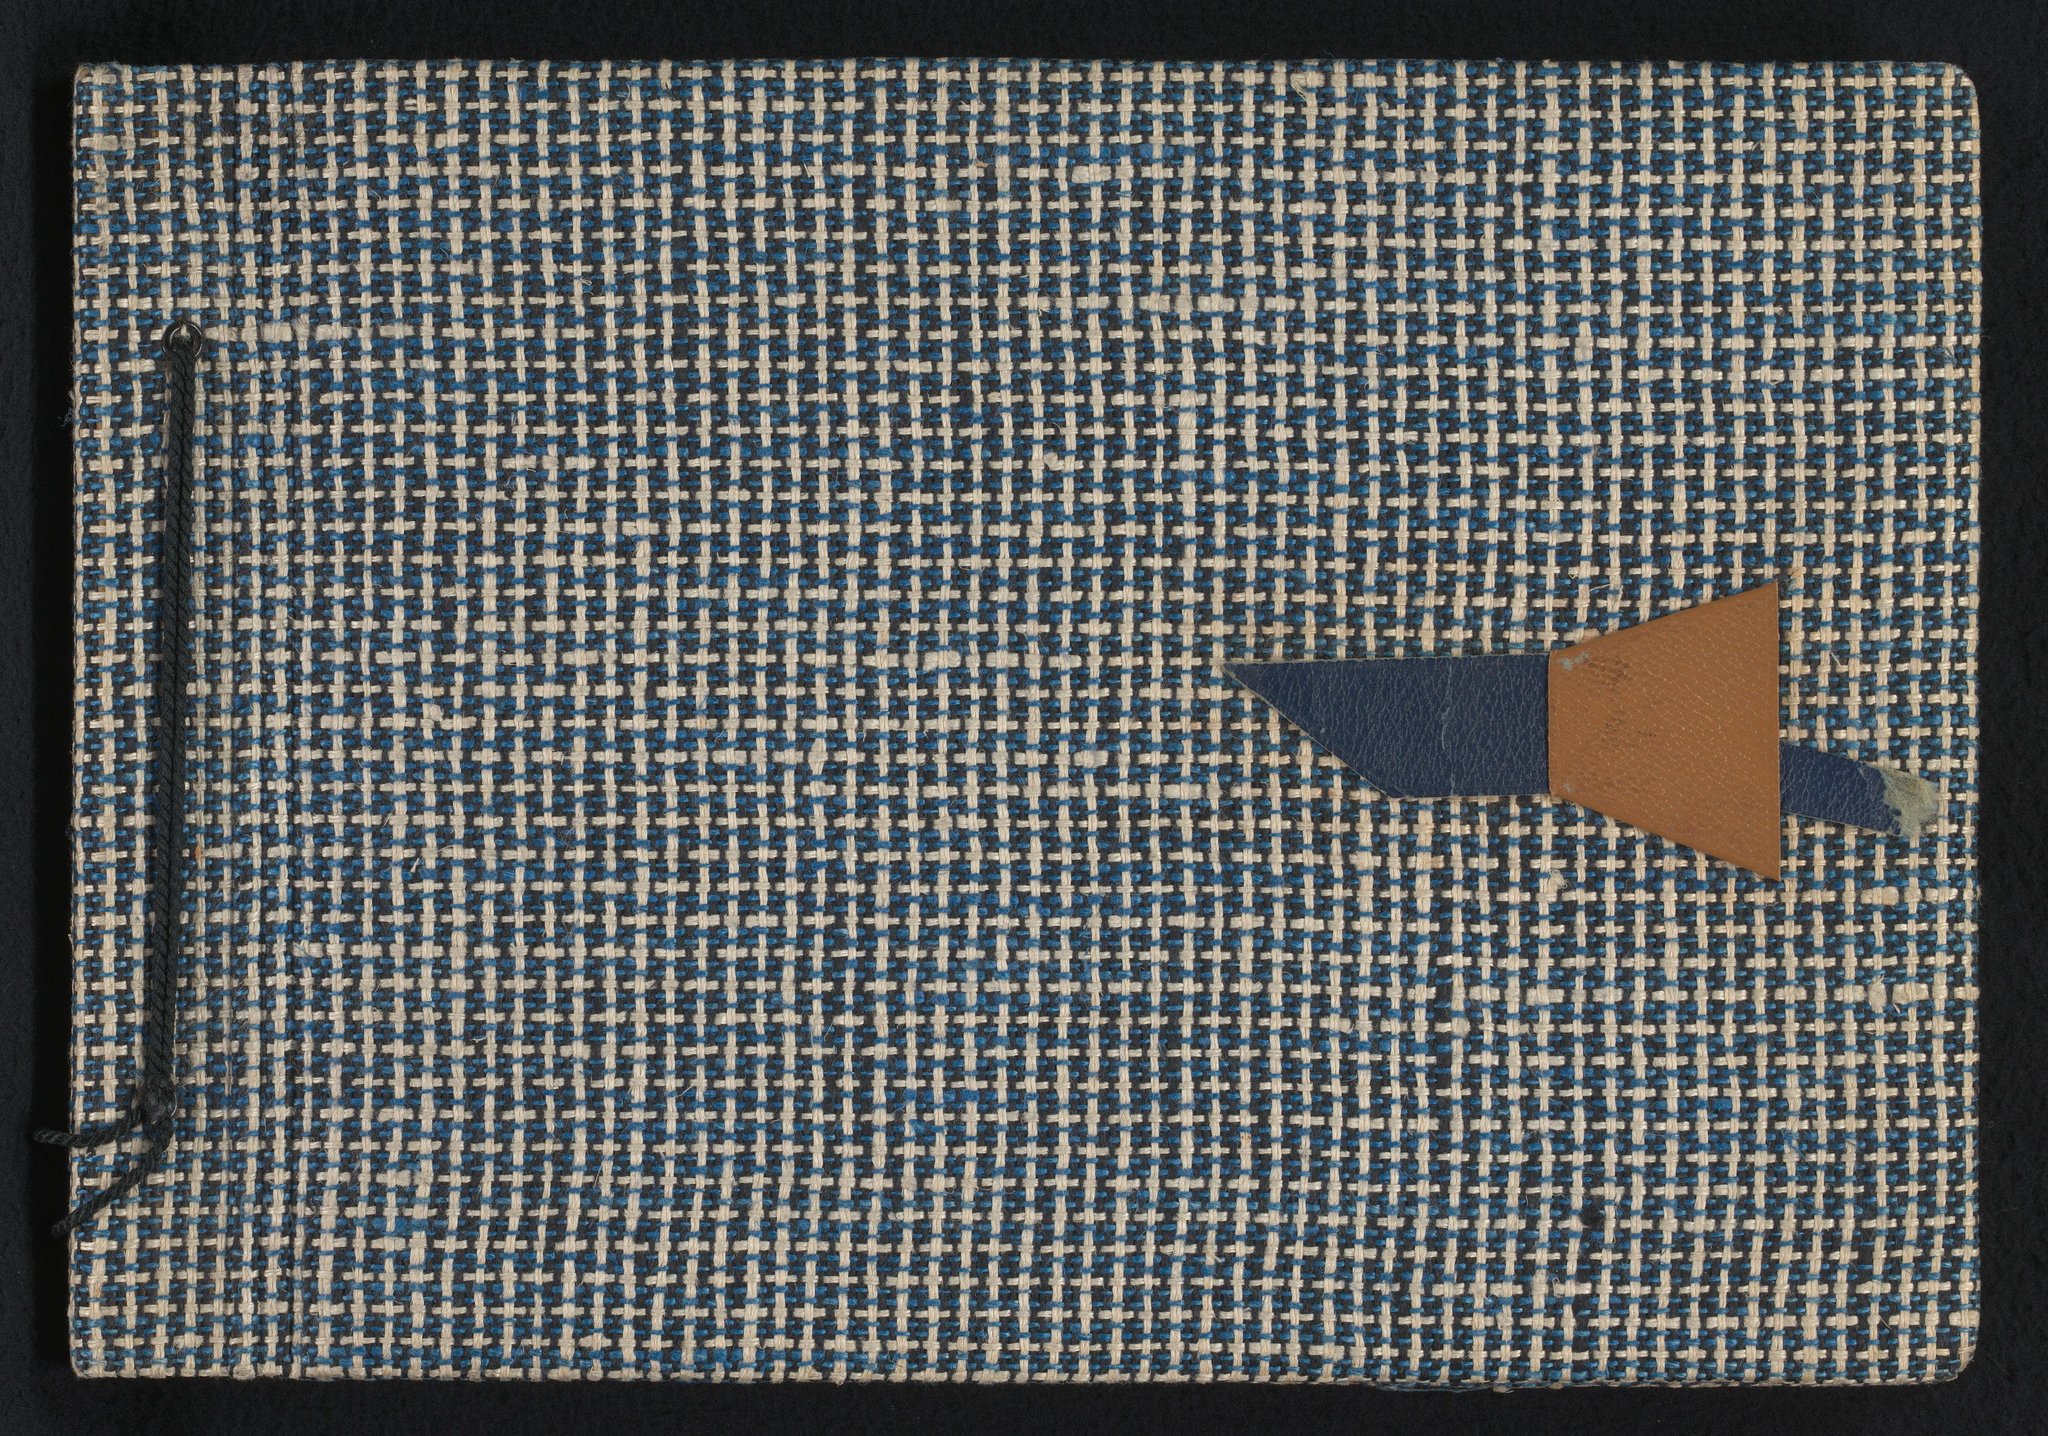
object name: photograph album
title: Officier in krijgsgevangenschap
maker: Anonymous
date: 1937-1948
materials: paper, photographic support, textile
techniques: gelatin silver print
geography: netherlands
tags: kamp stanislau, ede, tweede wereldoorlog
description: Fotoalbum met 25 bladen, waarvan de eerste zeven op beide zijden beplakt zijn met foto's. Het album bevat in totaal 57 foto's. Geruit, stoffen gewoven omslag in blauw en wit, koordje door de rug. Familiealbum met reisjes en familiefoto's en foto's van de officier met zijn gezin tijdens de mobilisatie in december 1939. Bij een aantal foto's uit de periode 1942 - ca. 1944 staat genoteerd welke zijn opgestuurd naar de vader die in Stalag 371 bij Stanislau in krijgsgevangenschap zit. De laatste foto's zijn van 1948 en tonen de Nederlandse officier weer thuis.